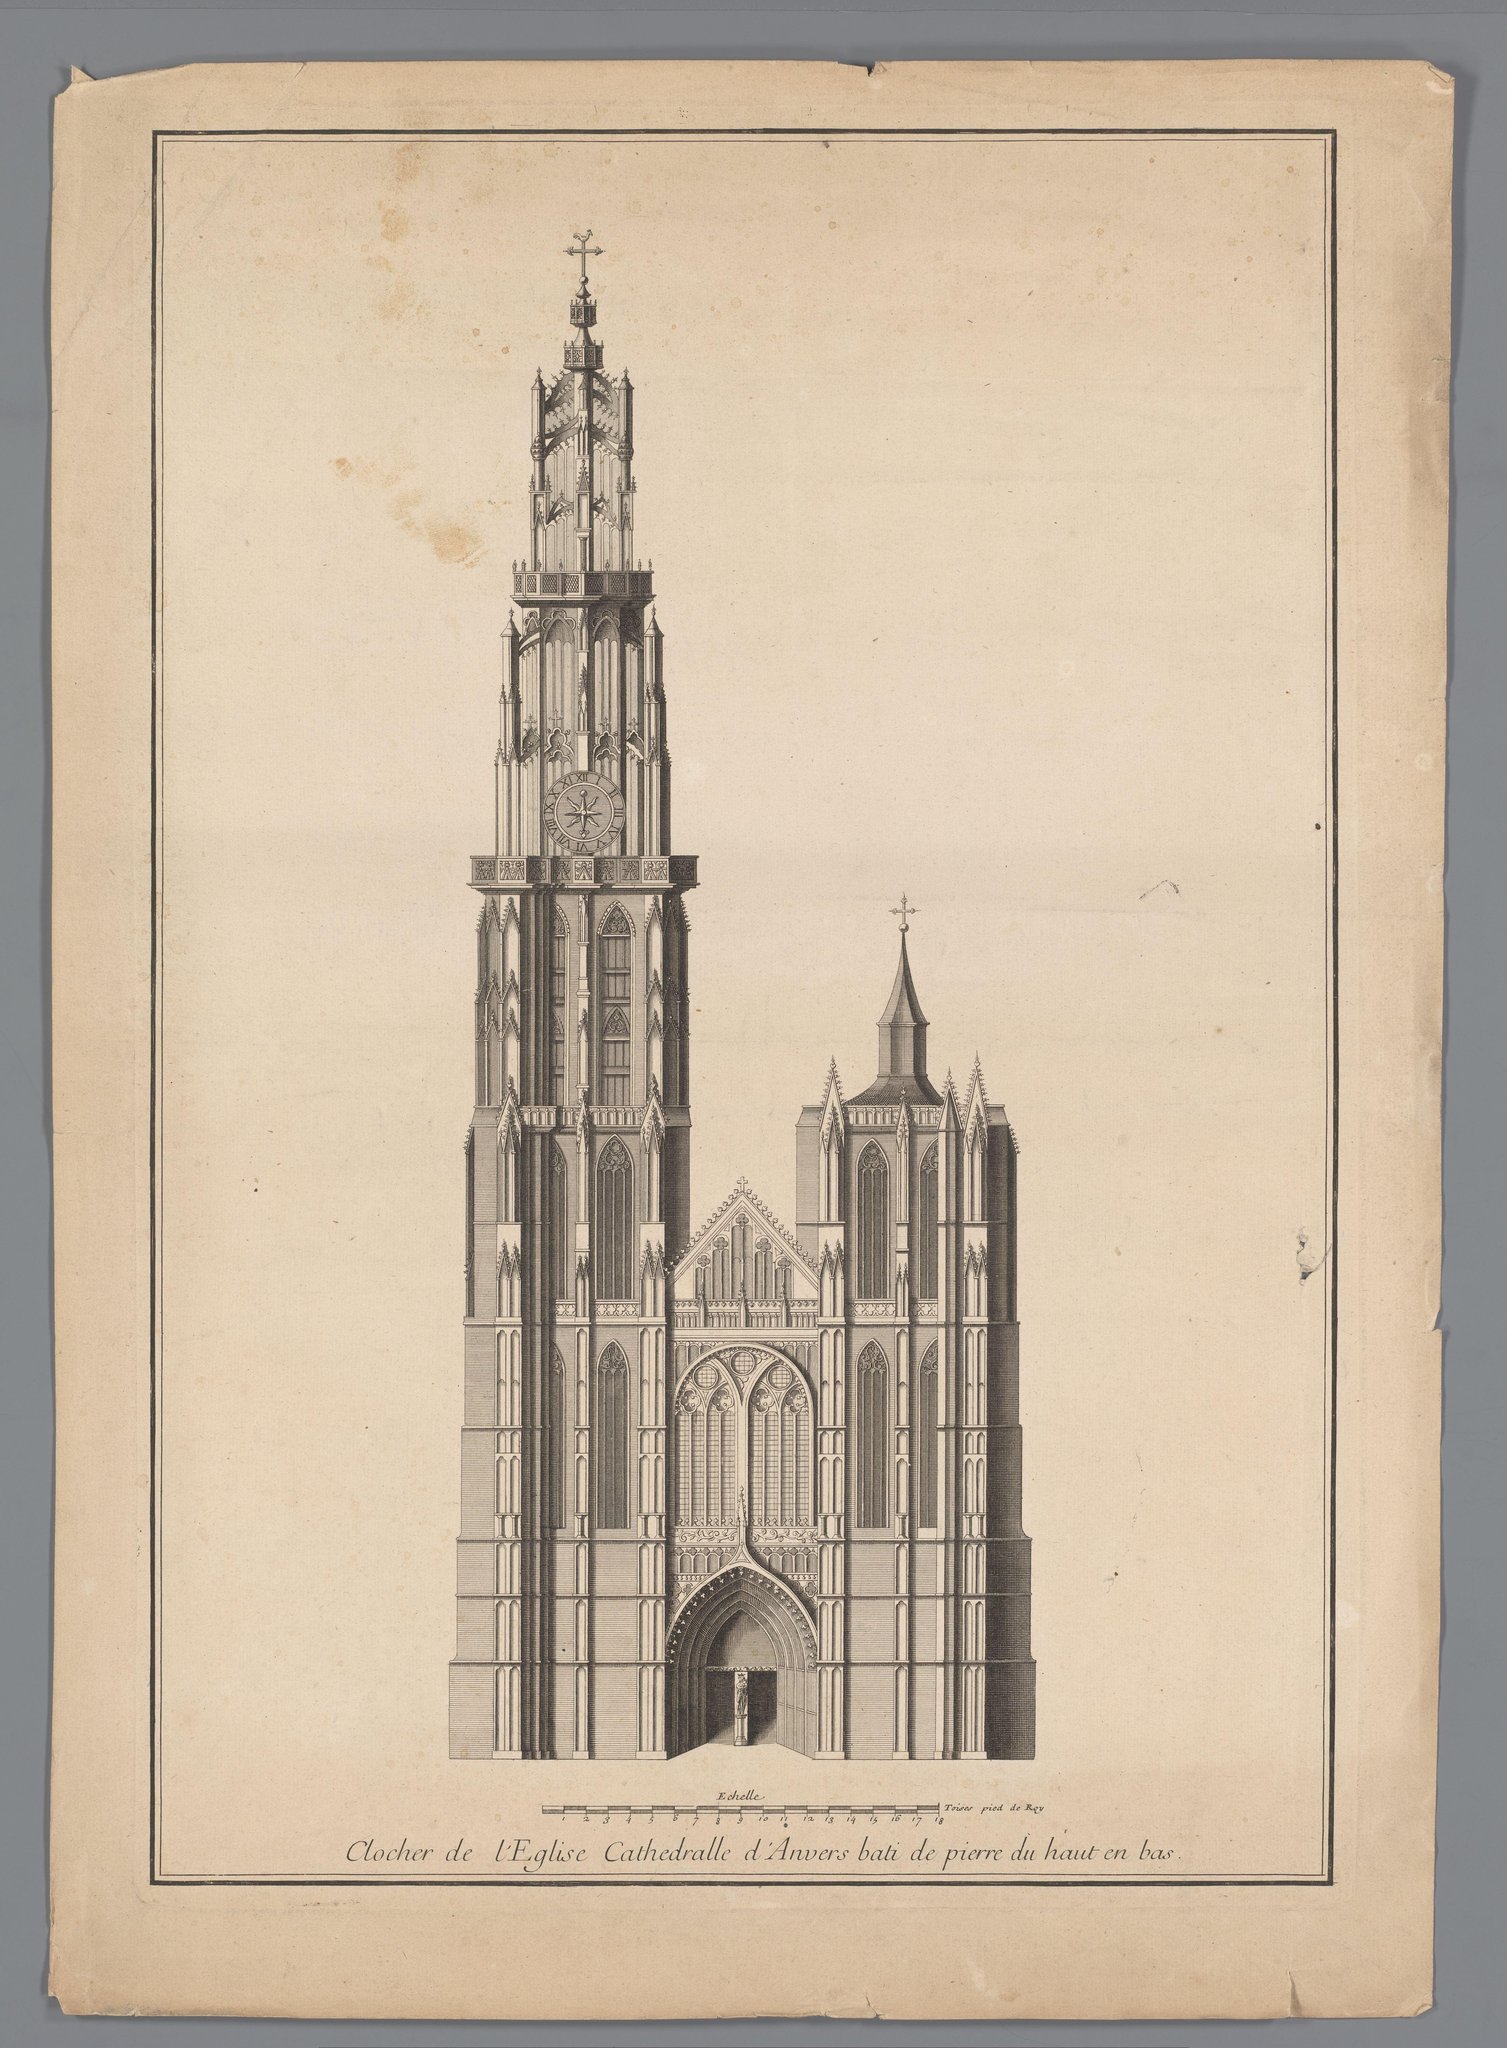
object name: print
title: Clocher de l'Eglise Cathedralle d'Anvers bati de pierre du haut en bas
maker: Anonymous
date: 1650-1750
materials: paper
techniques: etching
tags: church (exterior), antwerp